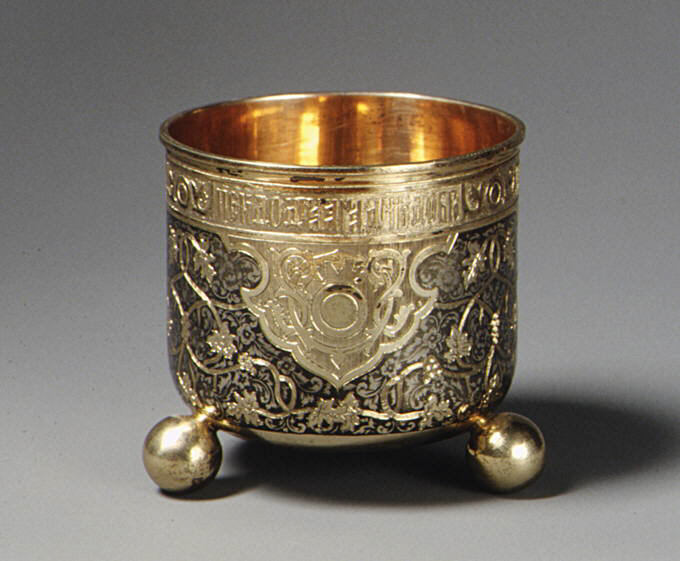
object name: tumbler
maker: andrei kovalskii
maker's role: maker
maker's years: 1827-1856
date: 1854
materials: niello, silver, silver gilt